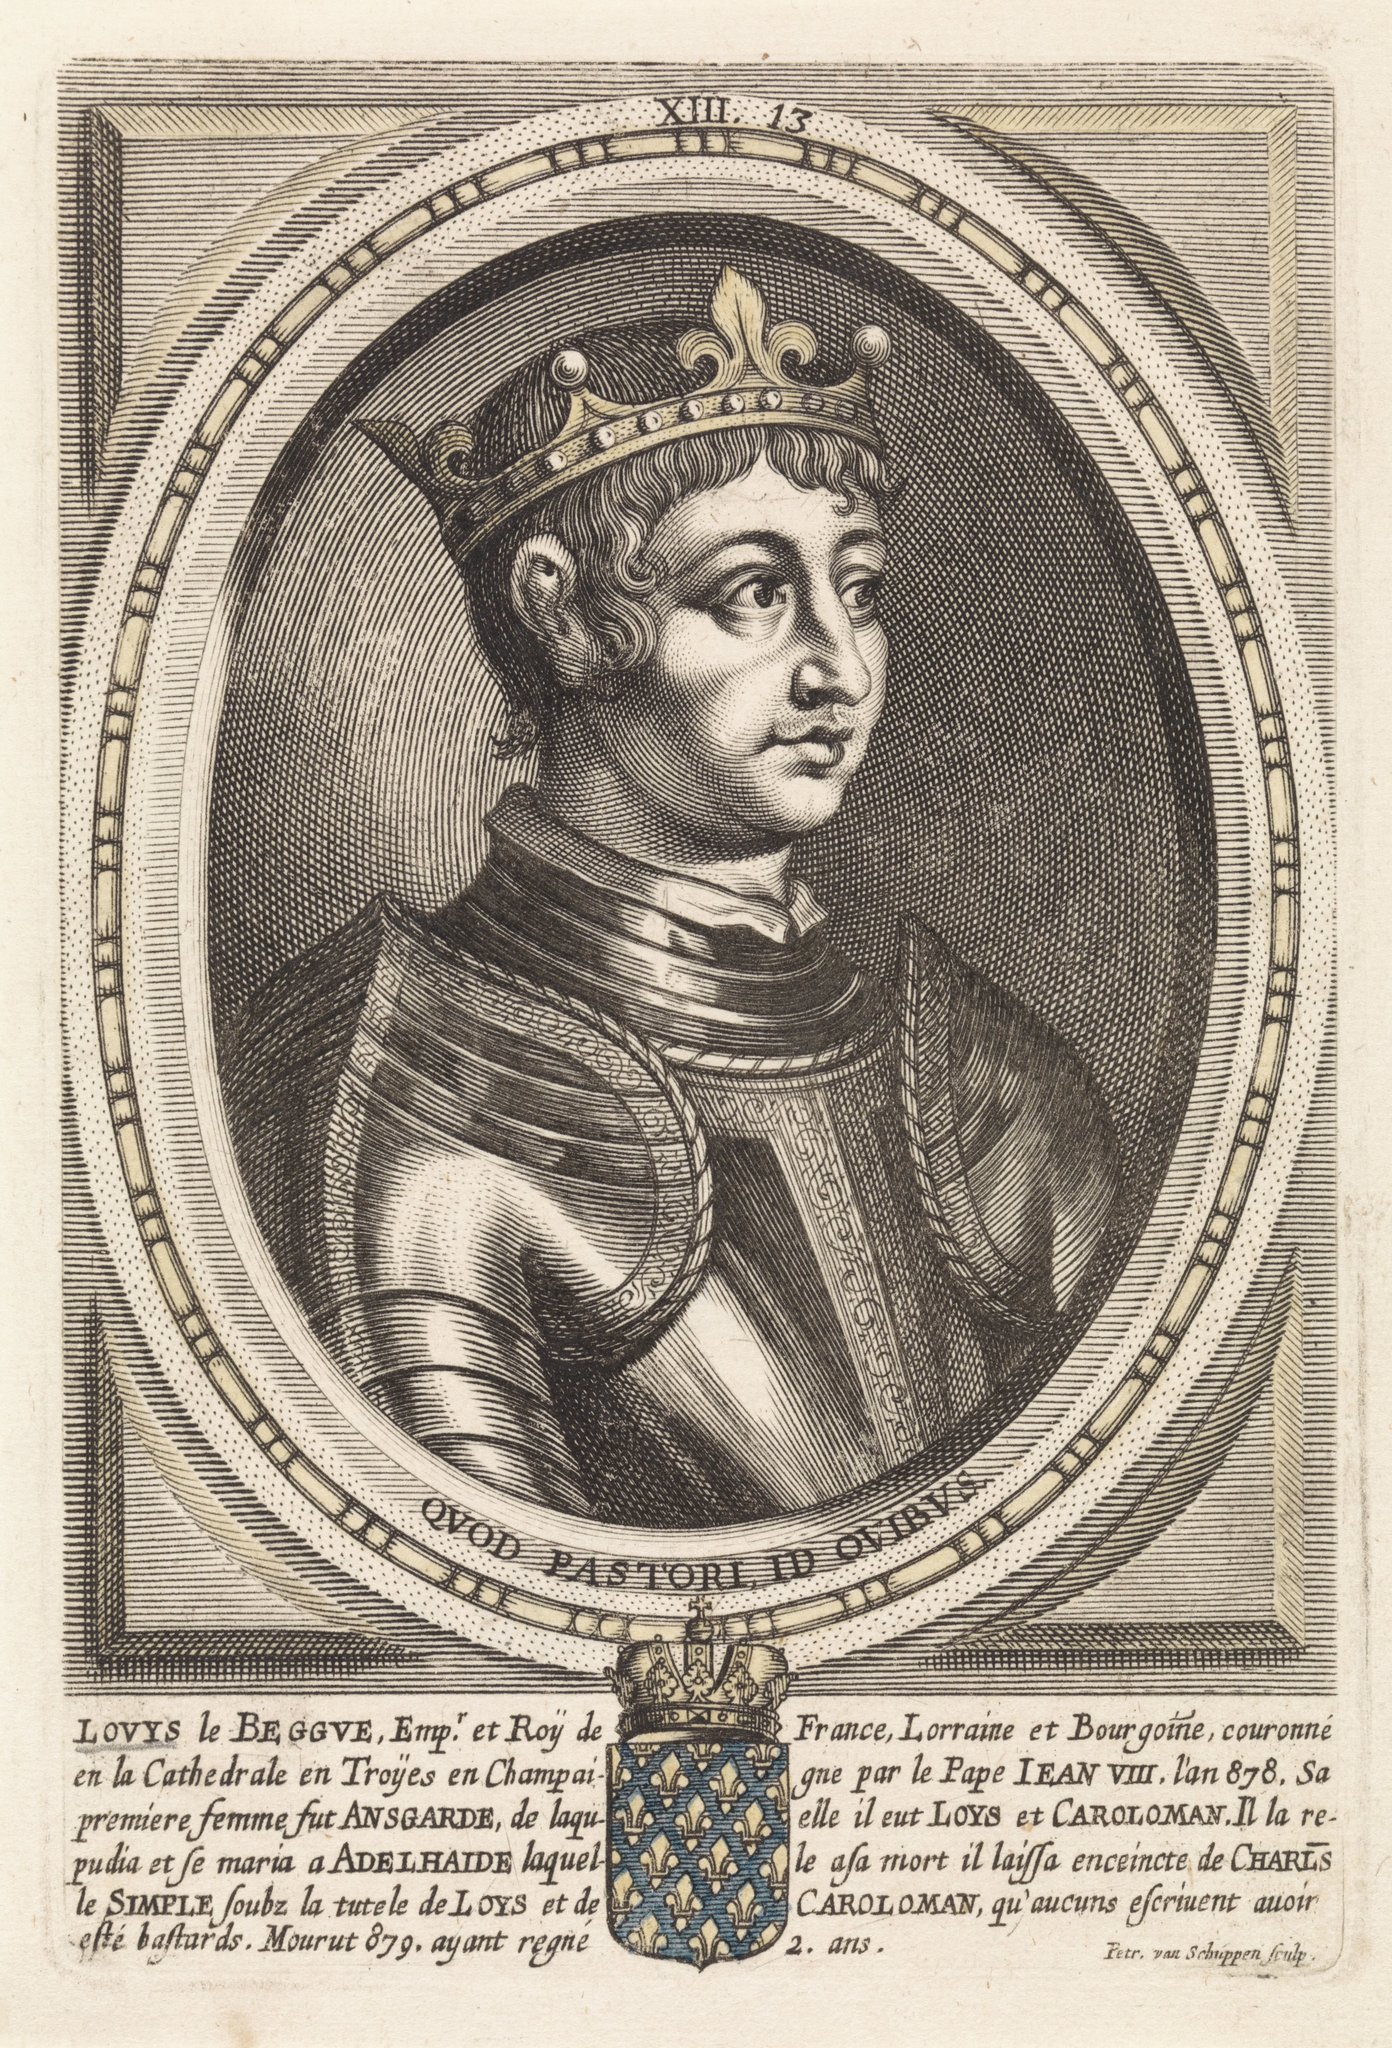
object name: book illustration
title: Portret van Lodewijk de Stamelaar, koning van Frankrijk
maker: pieter van schuppen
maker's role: print maker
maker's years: 1627-1702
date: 1660-1669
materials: paper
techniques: engraving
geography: paris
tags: koning, lodewijk ii (de stamelaar)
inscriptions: collector's mark: Lugt 2228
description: Portret van Lodewijk de Stamelaar met diens spreuk en ingekleurd wapenschild. Onder het portret een korte levensbeschrijving. Bovenaan genummerd 'XIII. 13'.